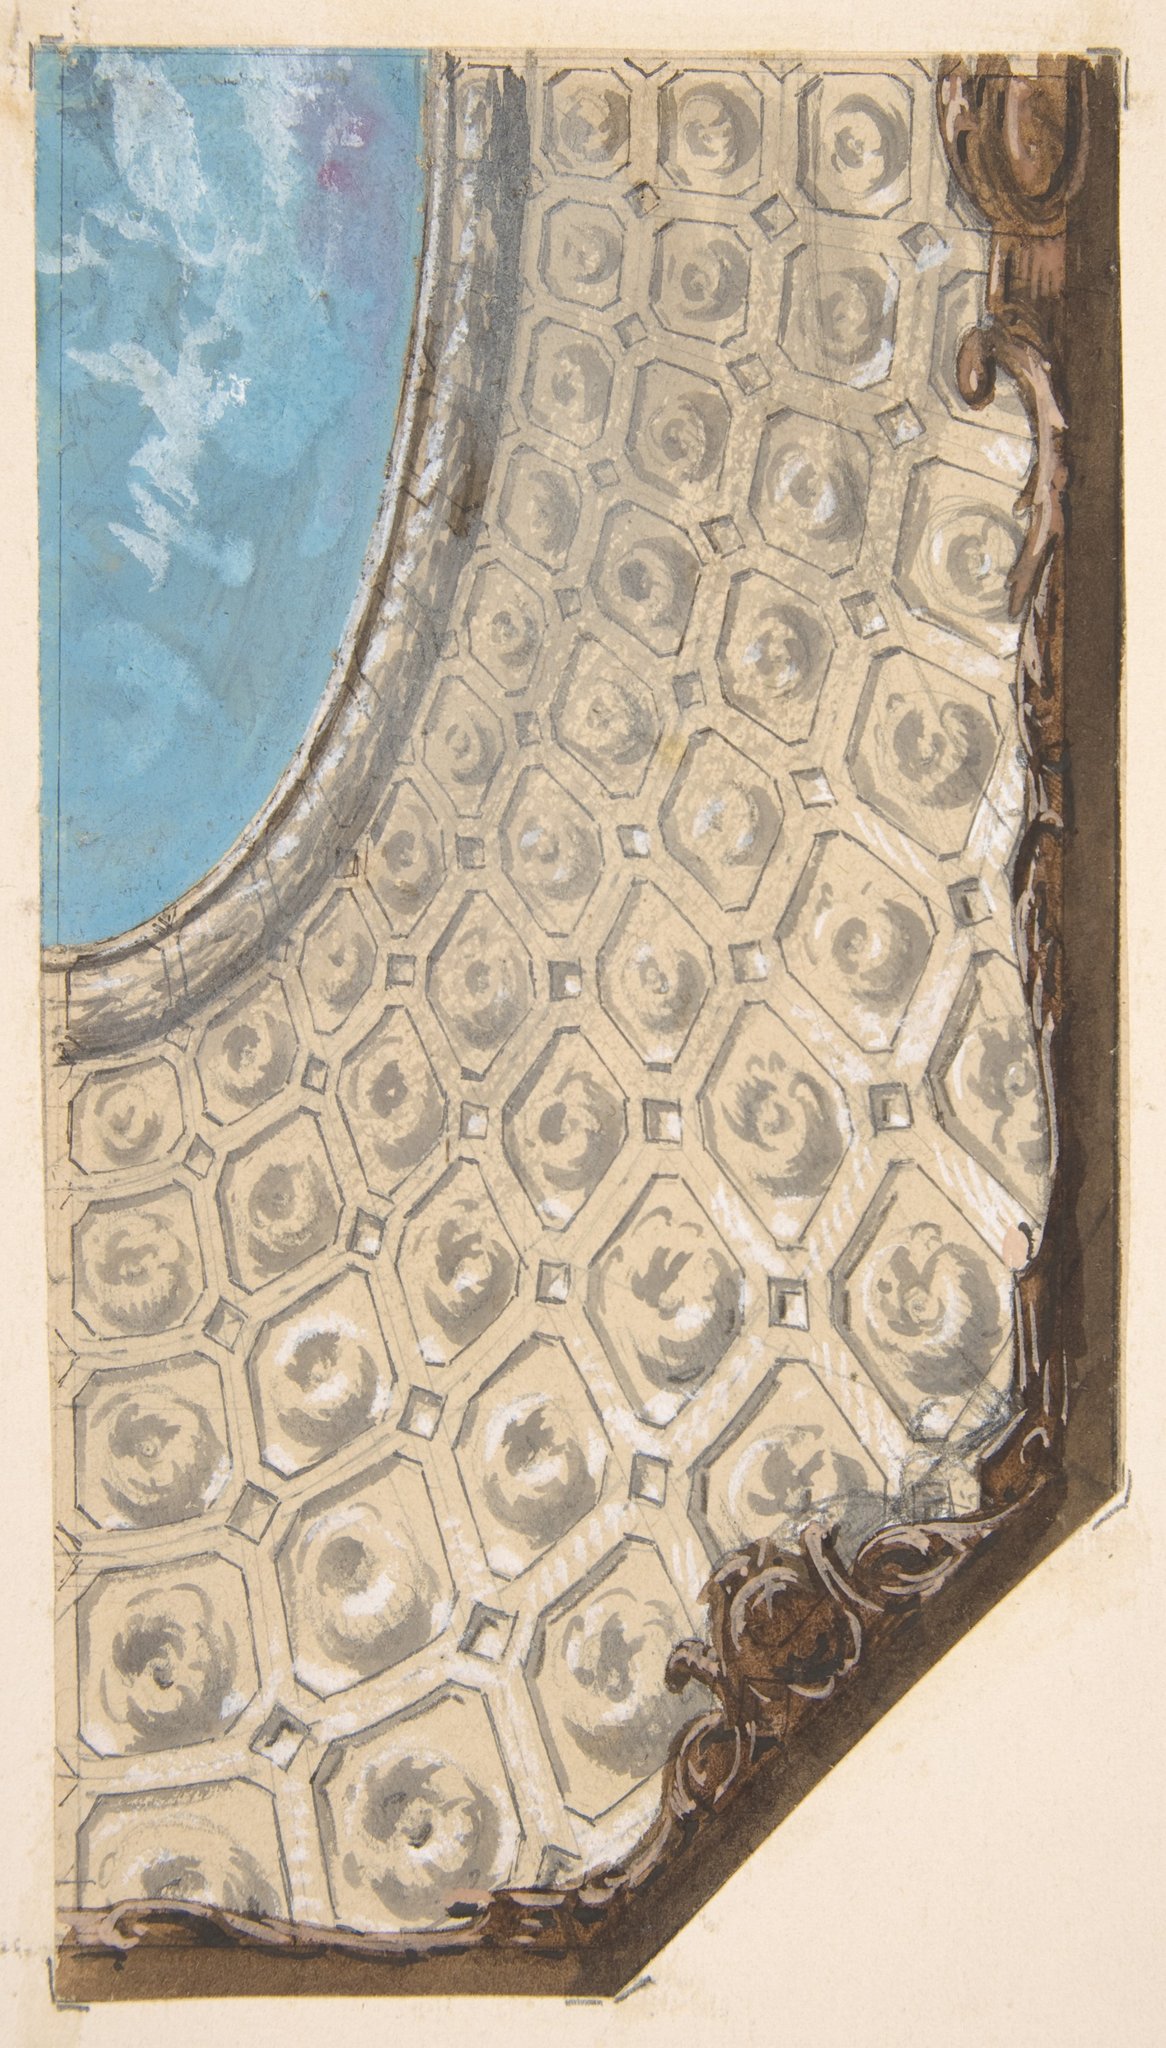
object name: drawing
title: Design for a coffered ceiling with a central oval painted in clouds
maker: jules-edmond-charles lachaise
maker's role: artist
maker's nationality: french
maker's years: 1897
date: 1830-1897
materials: graphite, ink, watercolor, paper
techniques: pen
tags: ceilings